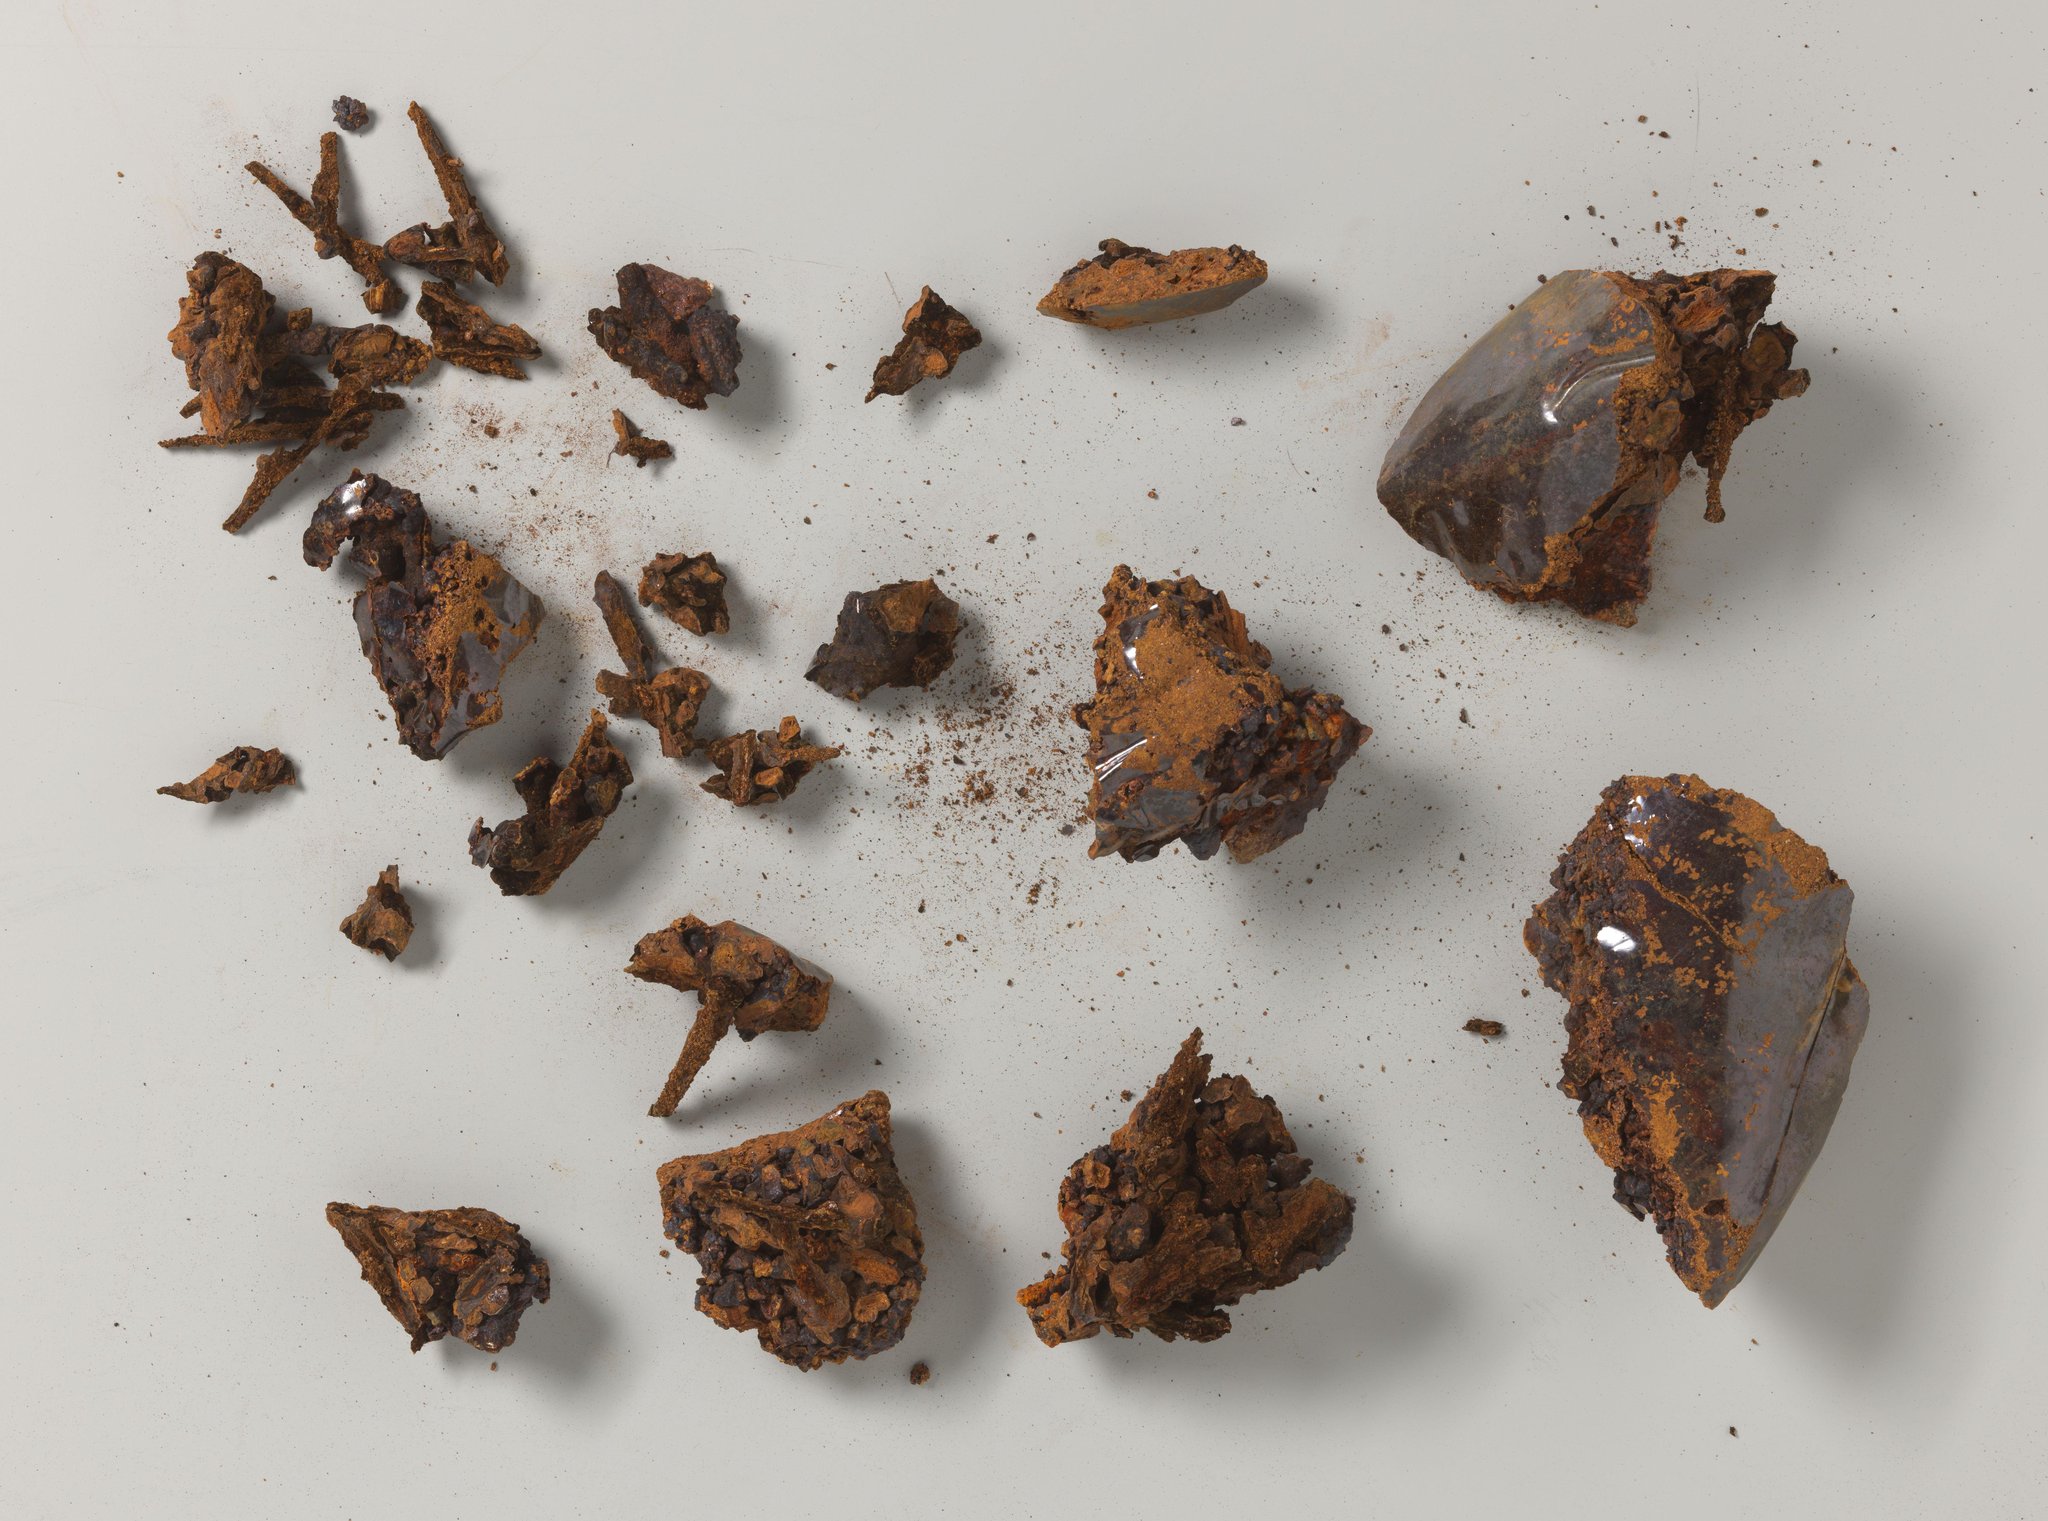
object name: nagel, spijker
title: Zak met concretie met daarin spijkers uit het wrak van de Oostindiëvaarder Hollandia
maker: Anonymous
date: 1700-1743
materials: stone, iron